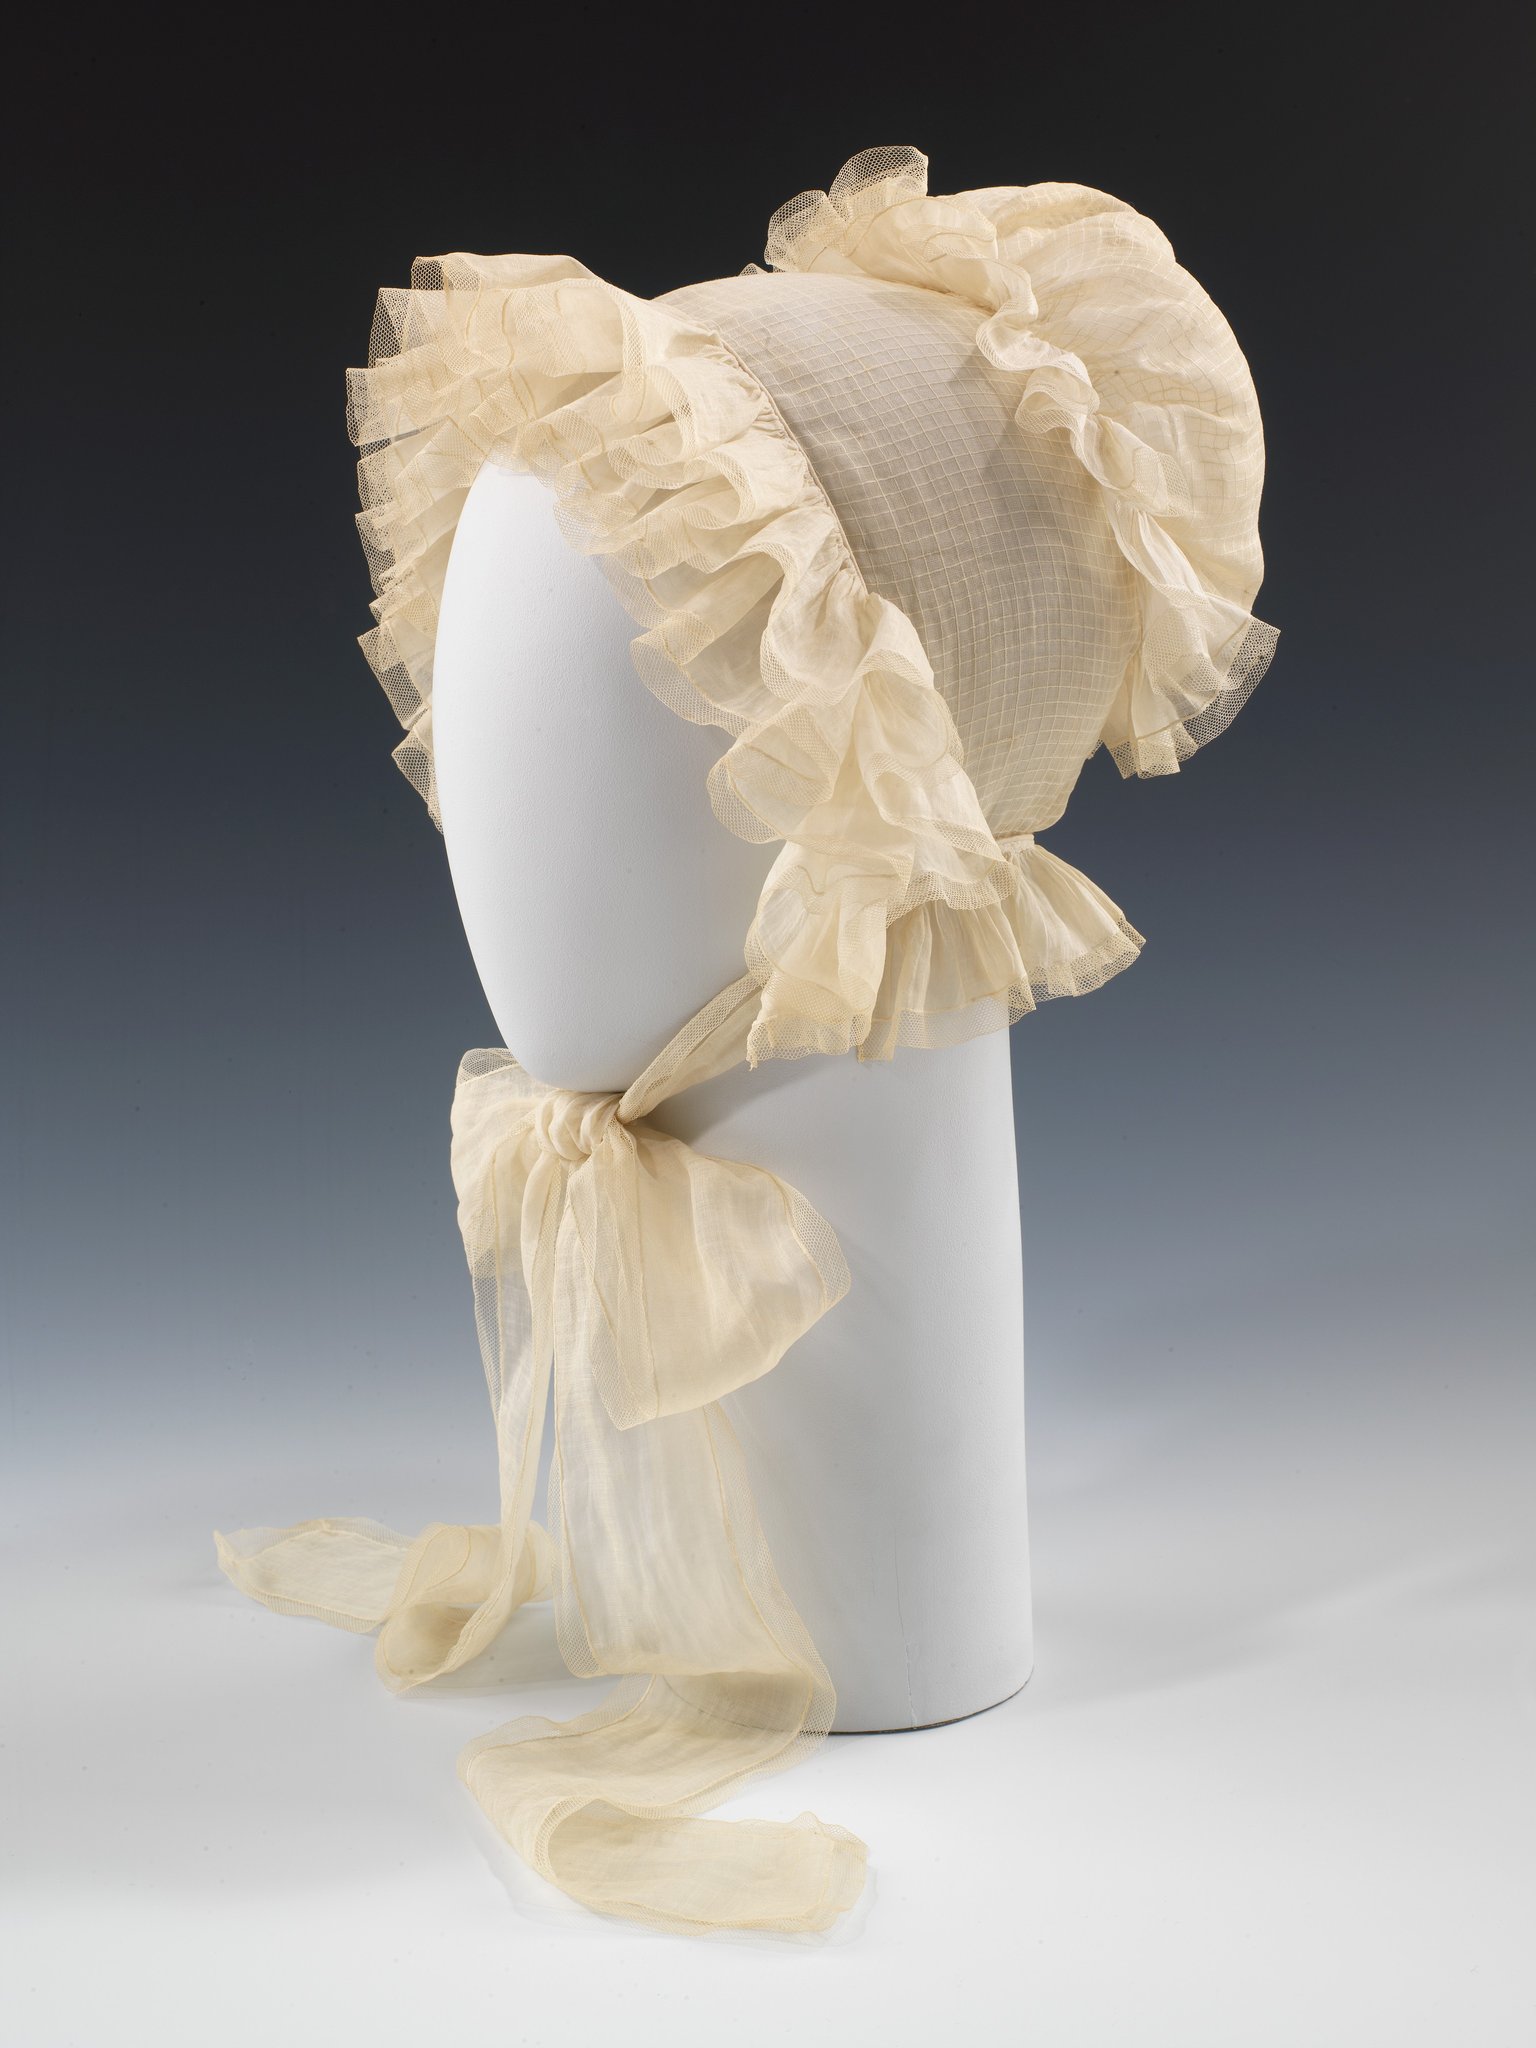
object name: morning cap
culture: american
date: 1835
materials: cotton